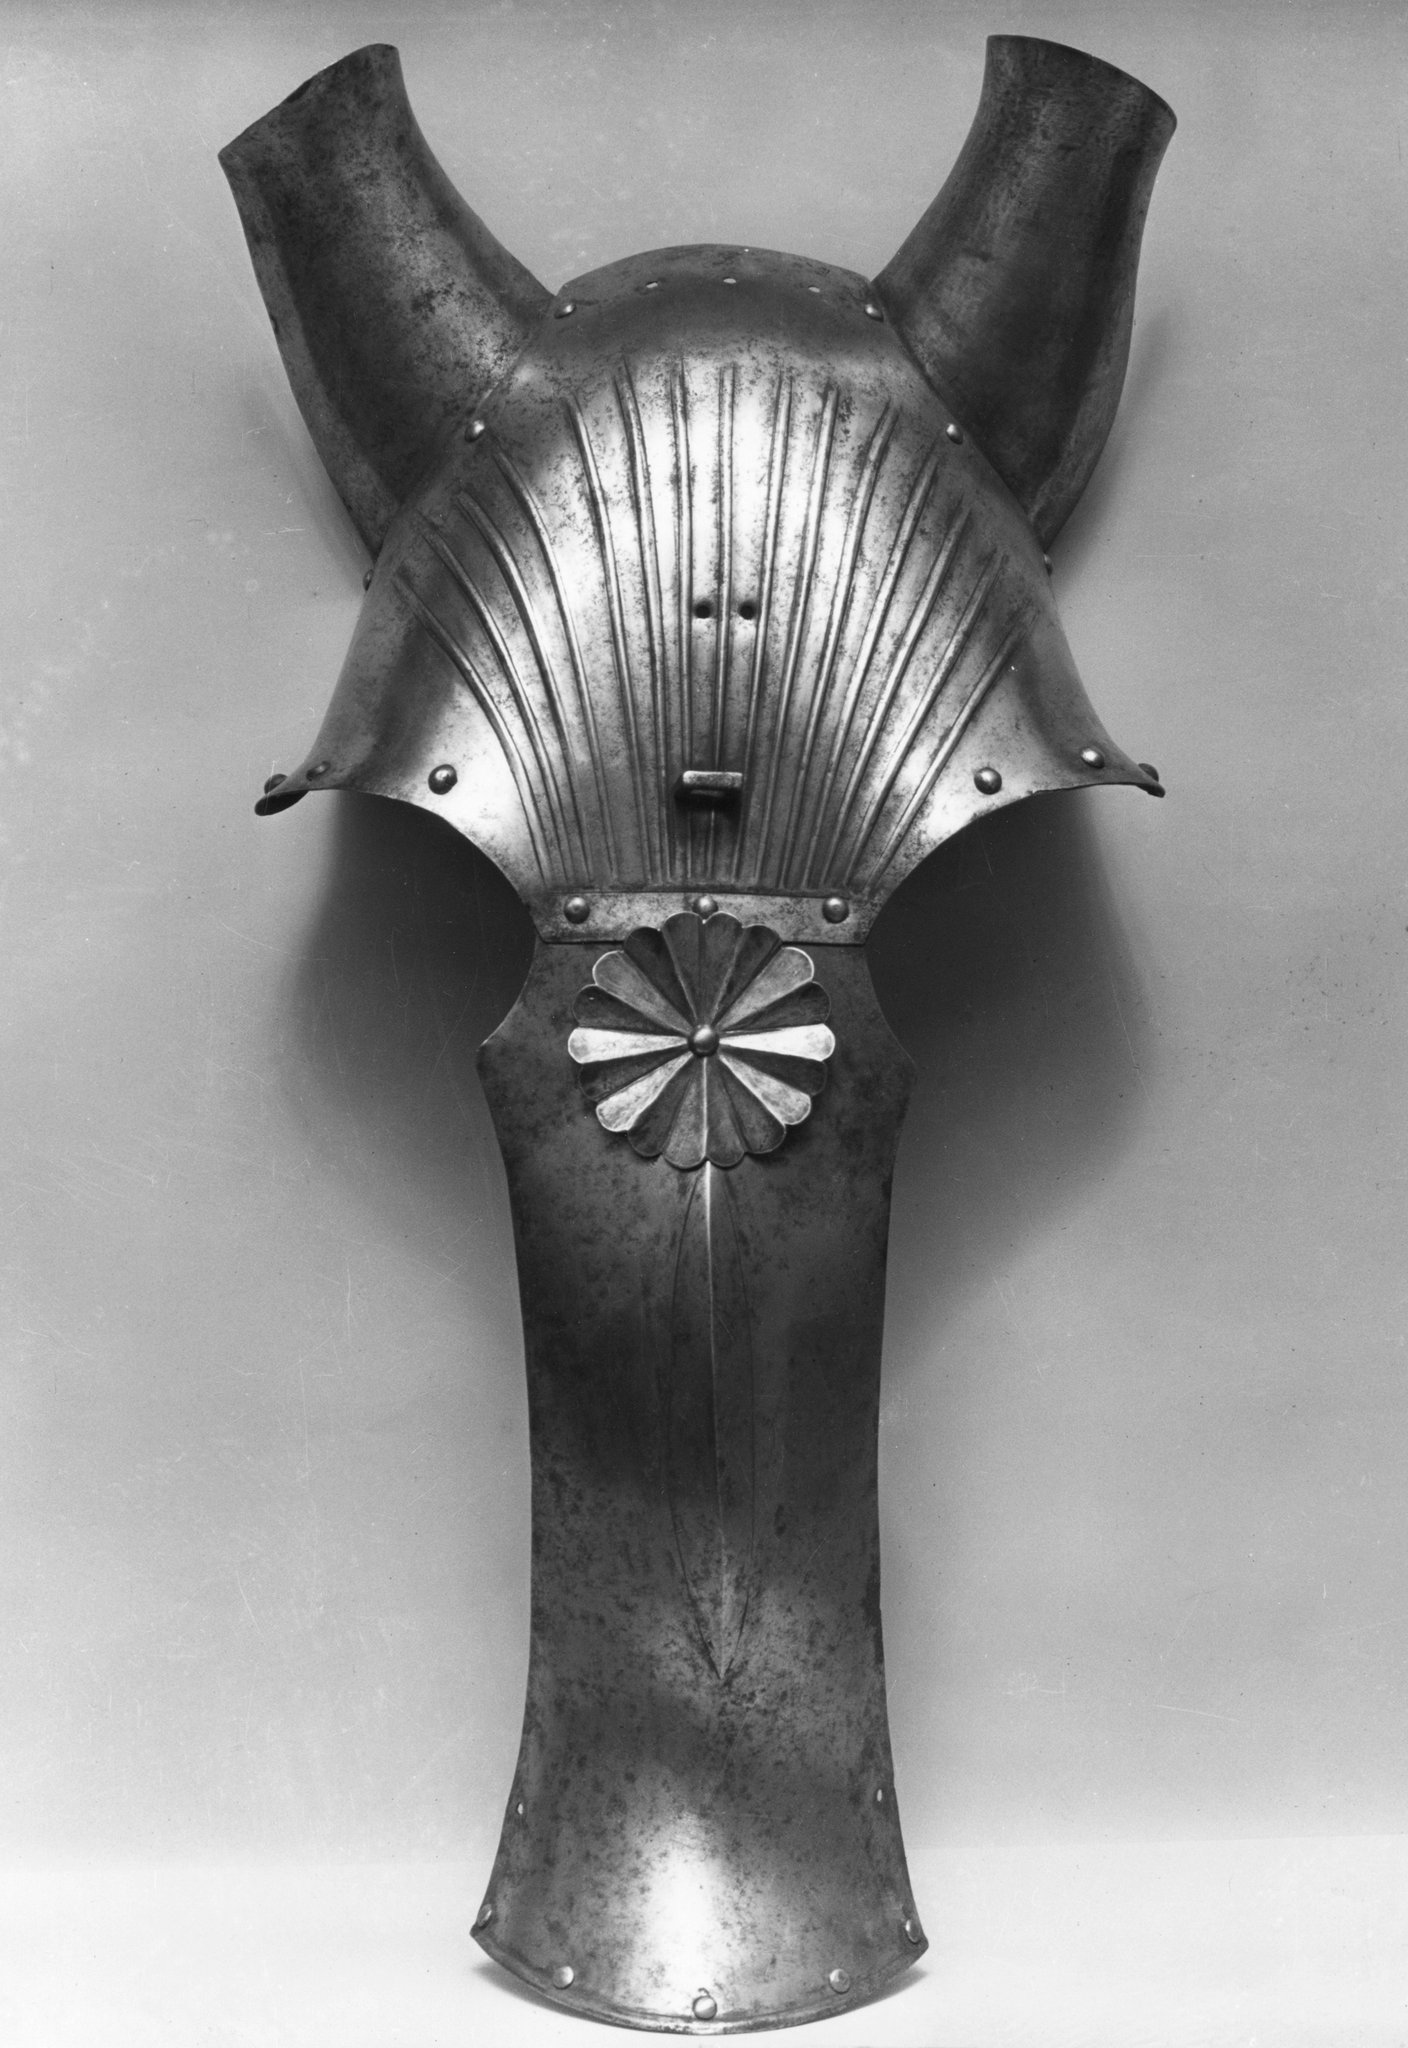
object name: shaffron horse's head defense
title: Shaffron (Horse's Head Defense)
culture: german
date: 1501-1600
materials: steel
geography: germany